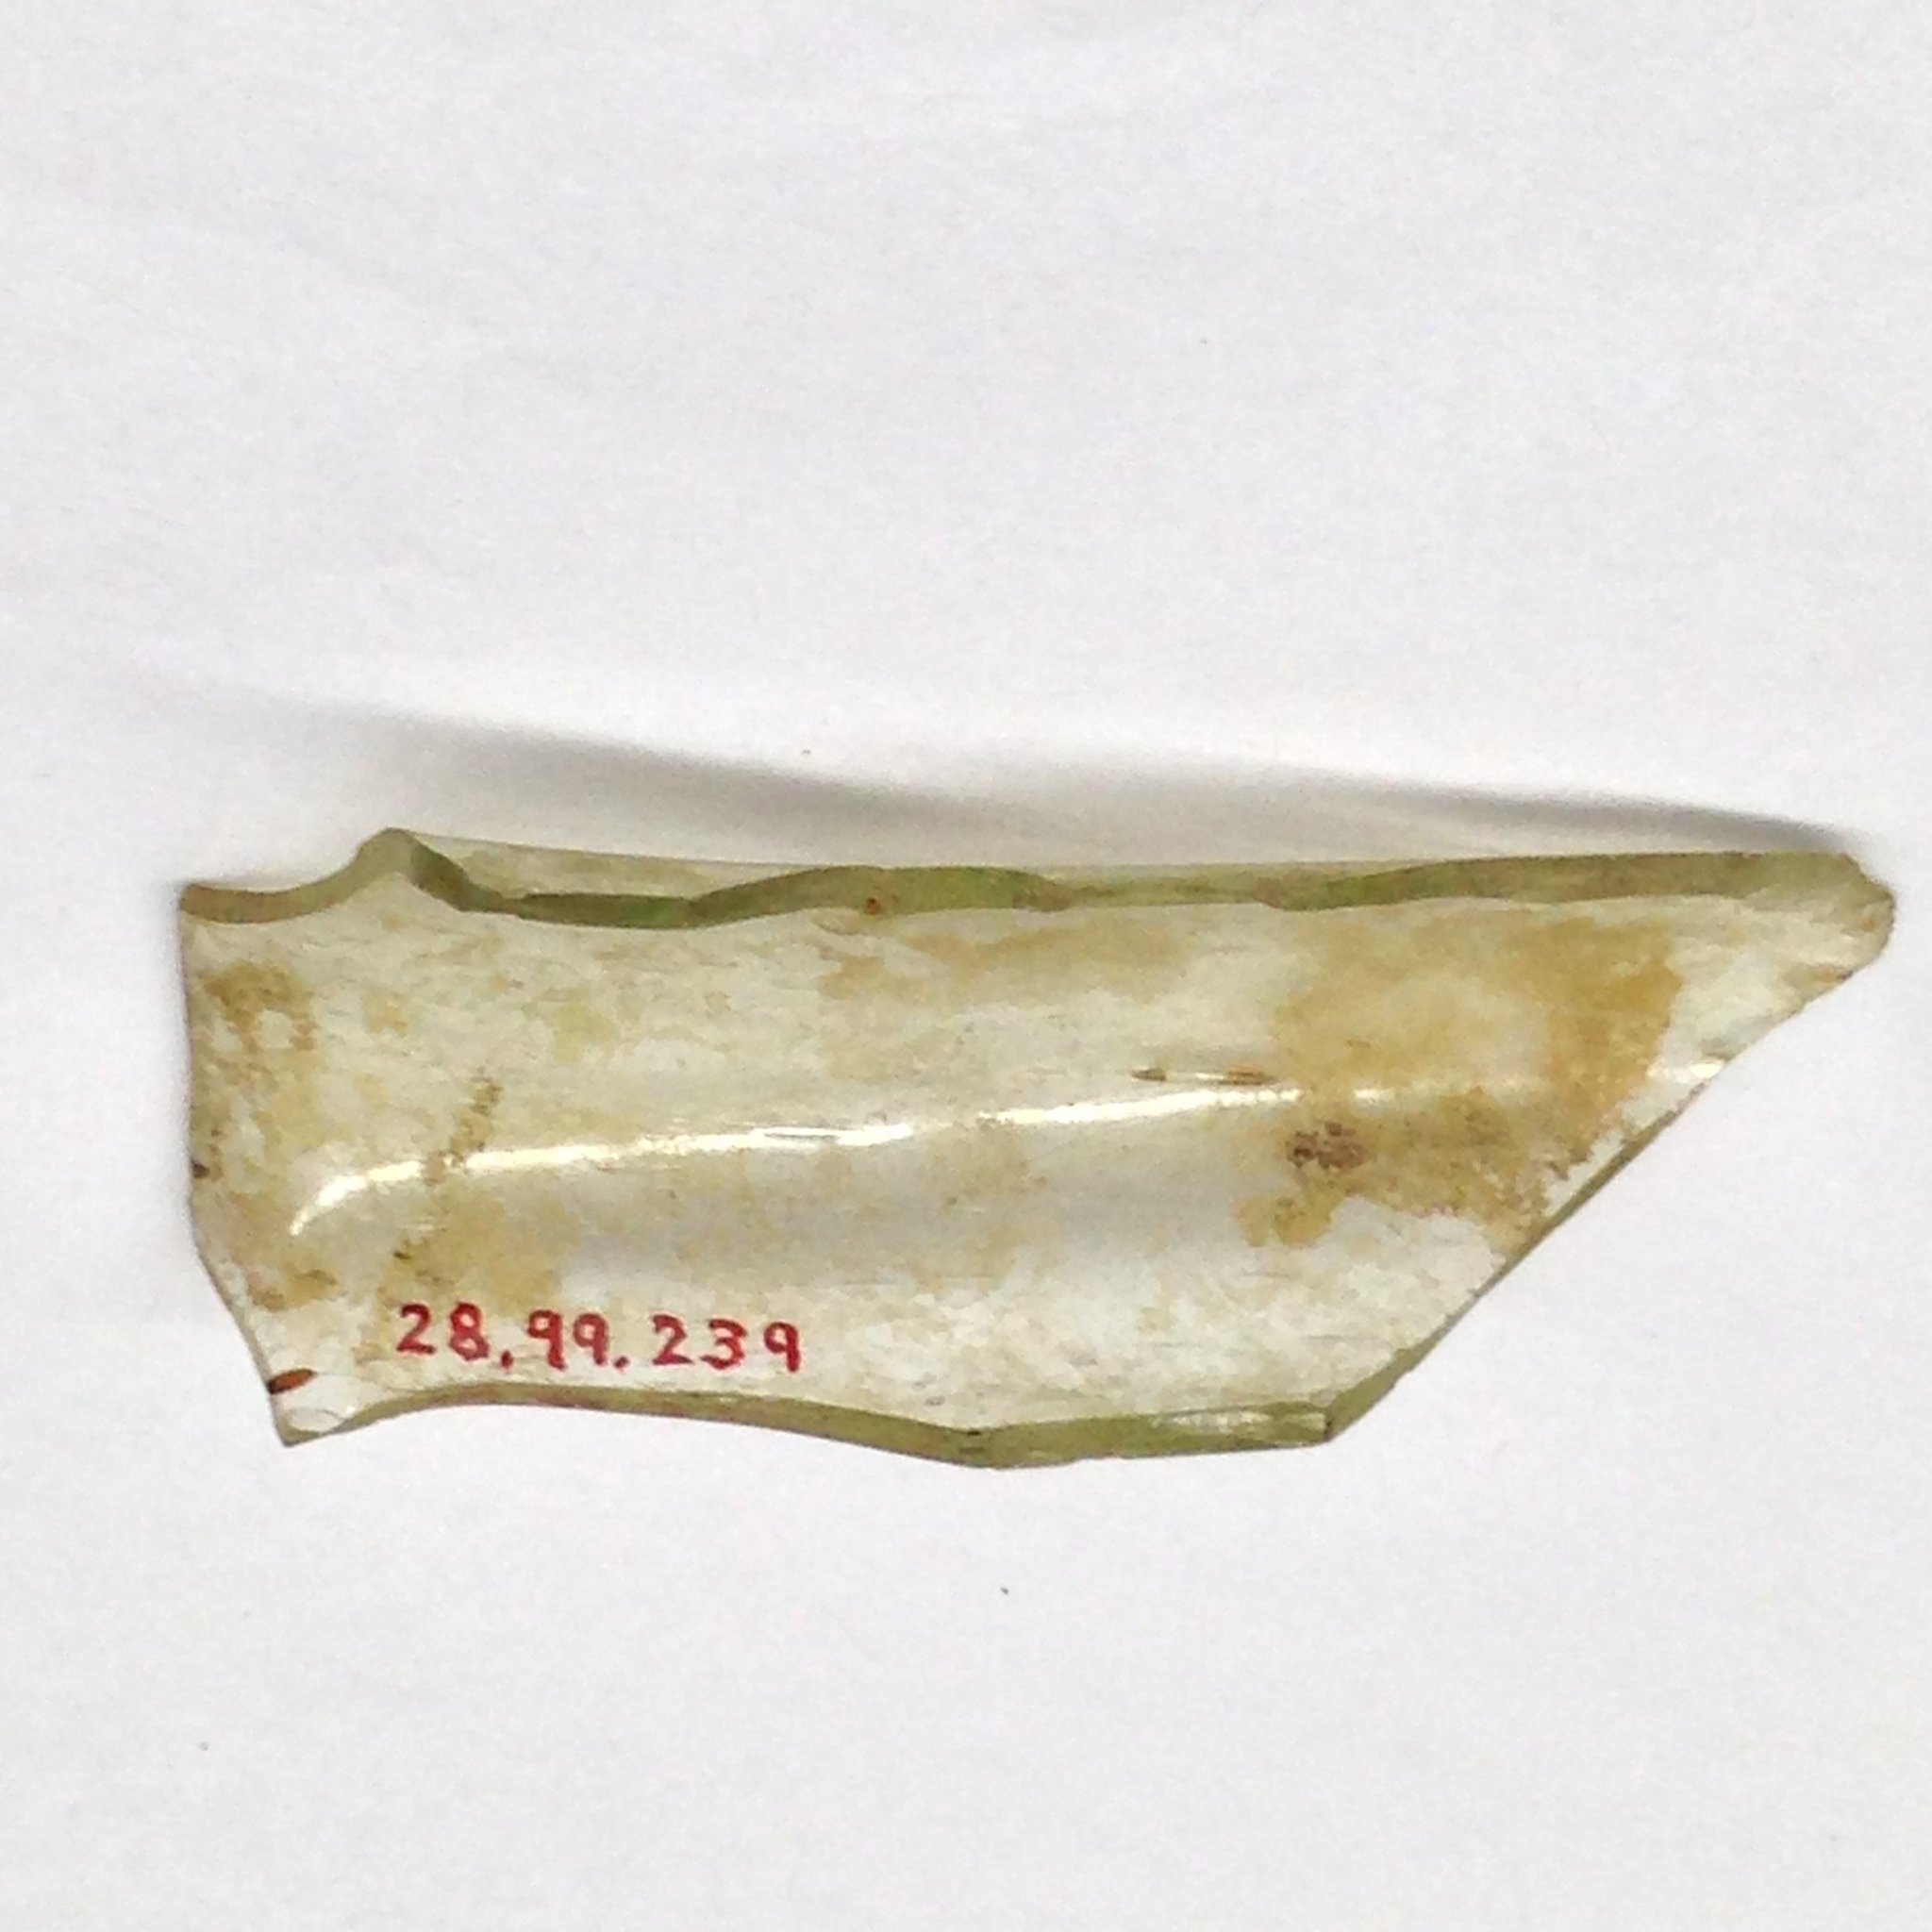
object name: fragment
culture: european or middle eastern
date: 1150-1250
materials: ceramic, glass